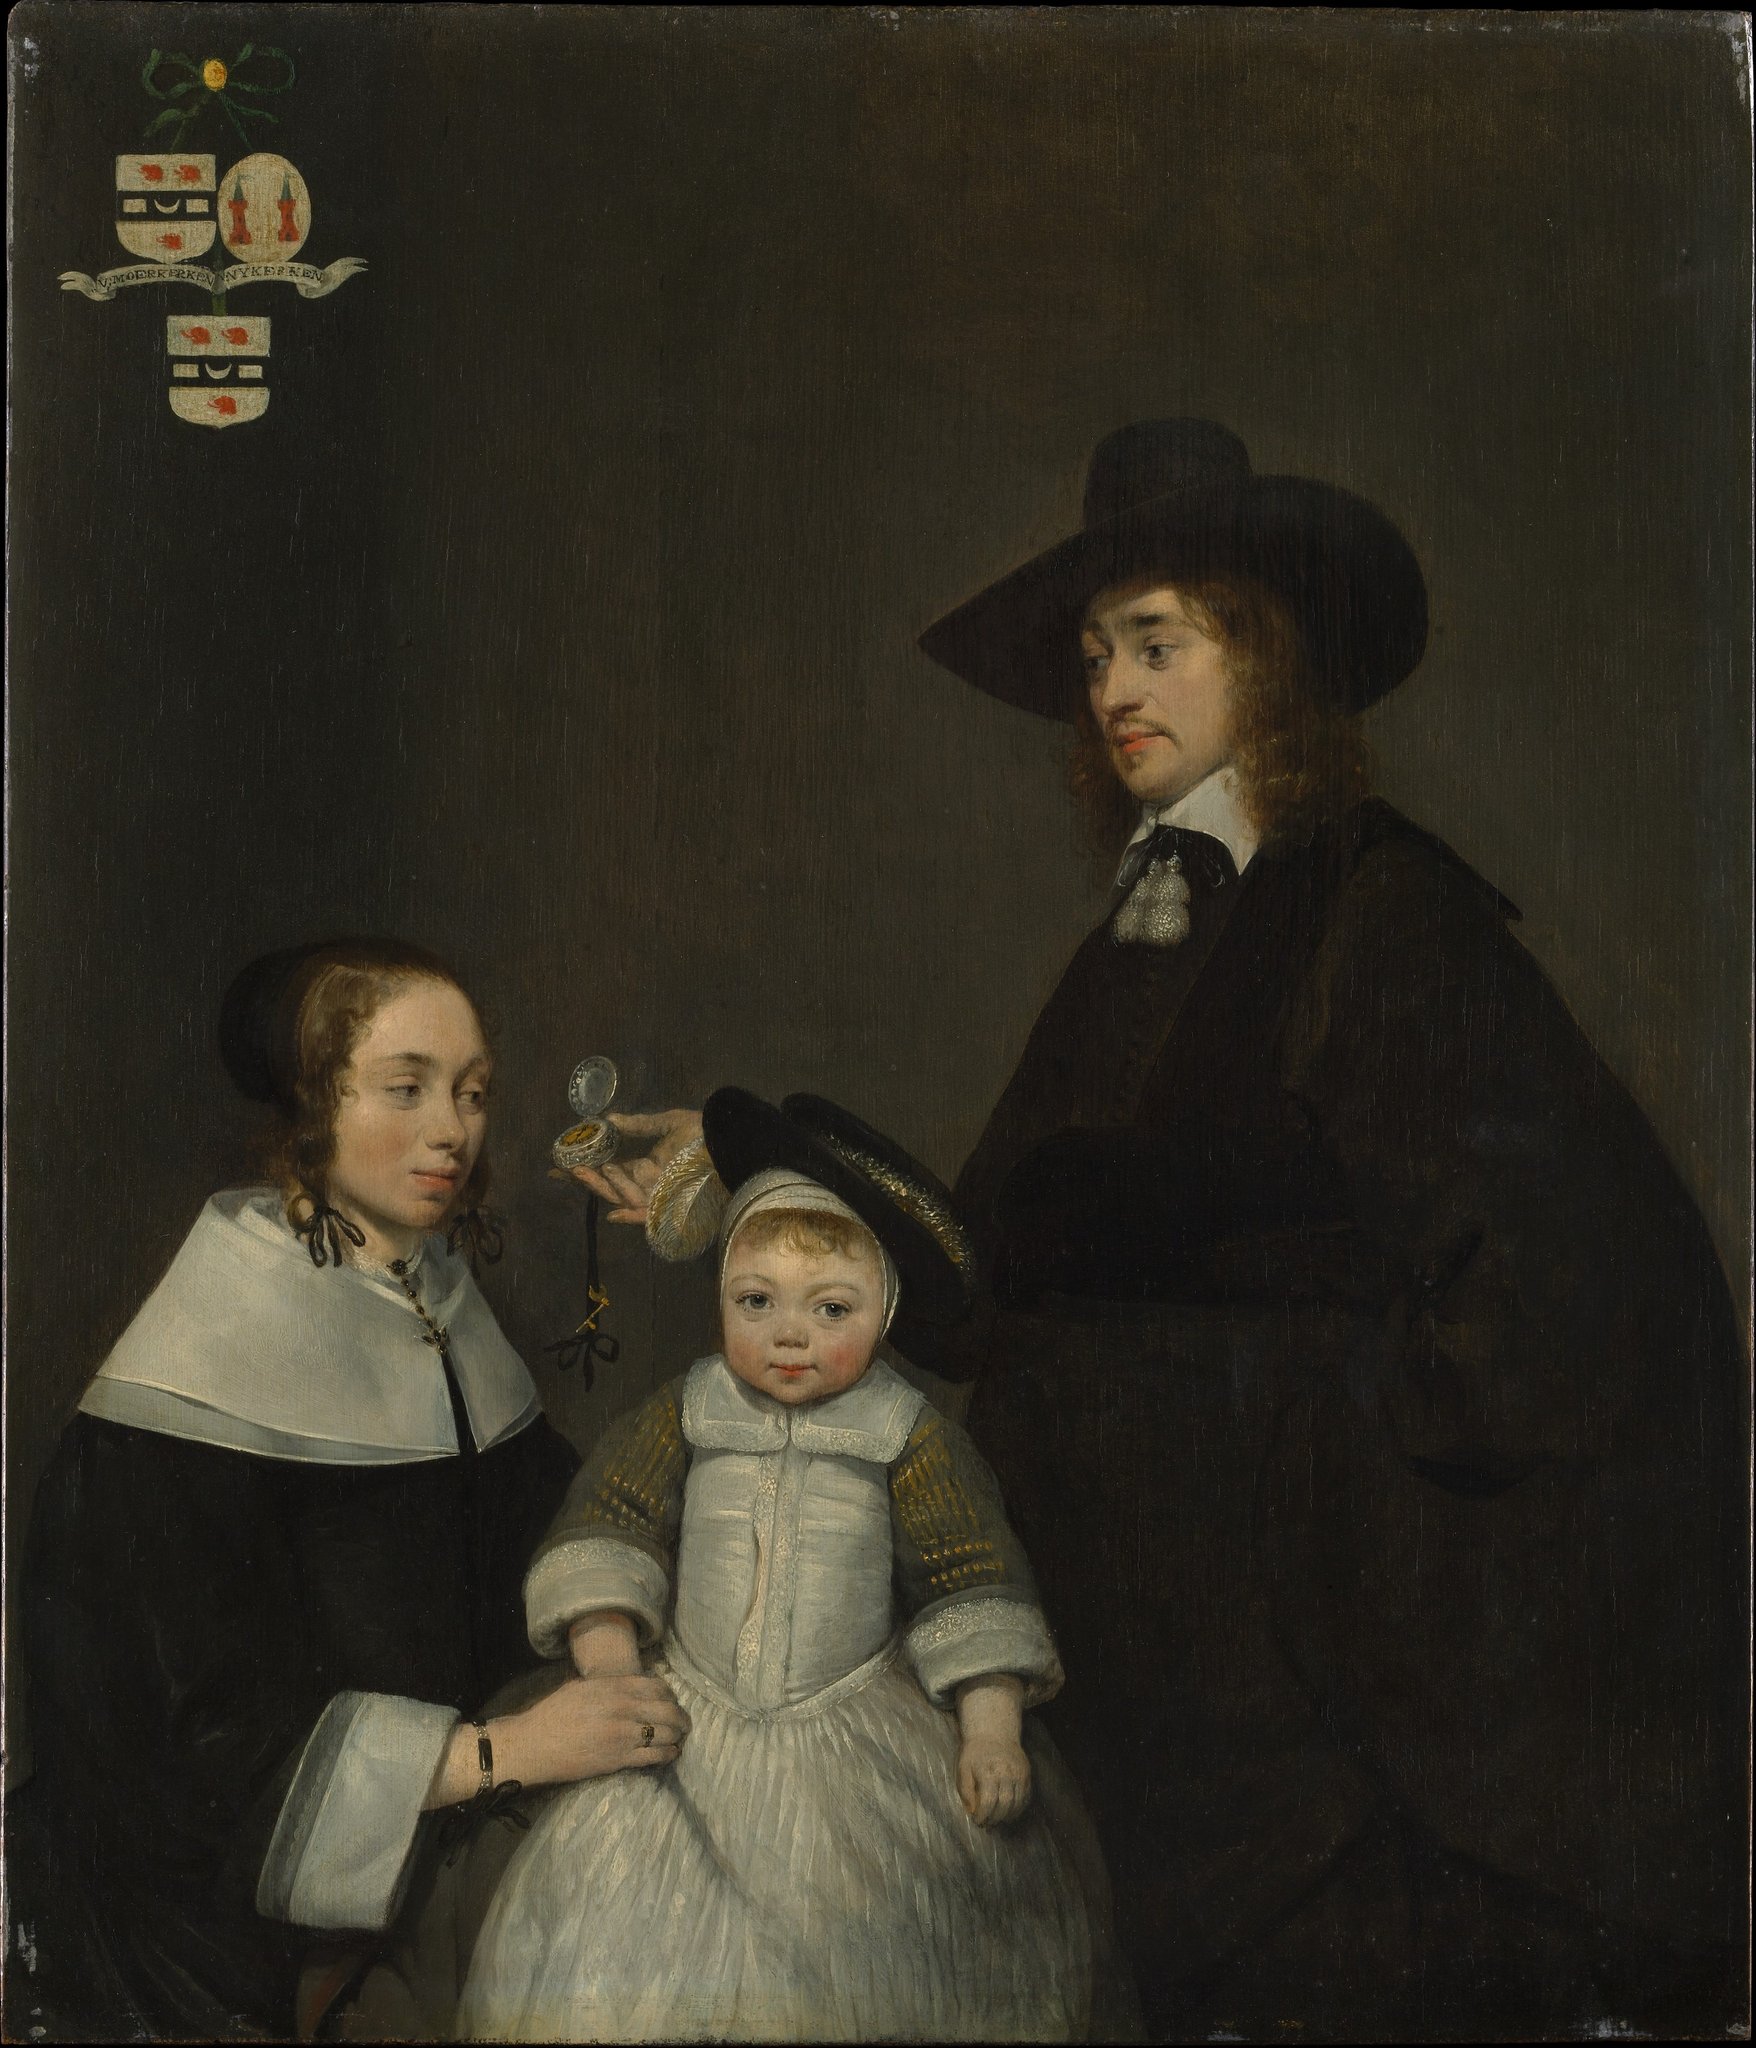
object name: painting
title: The Van Moerkerken Family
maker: gerard ter borch the younger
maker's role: artist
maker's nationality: dutch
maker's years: 1617-1681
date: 1653-1654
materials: oil, wood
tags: watches,boys,men,portraits,women,family